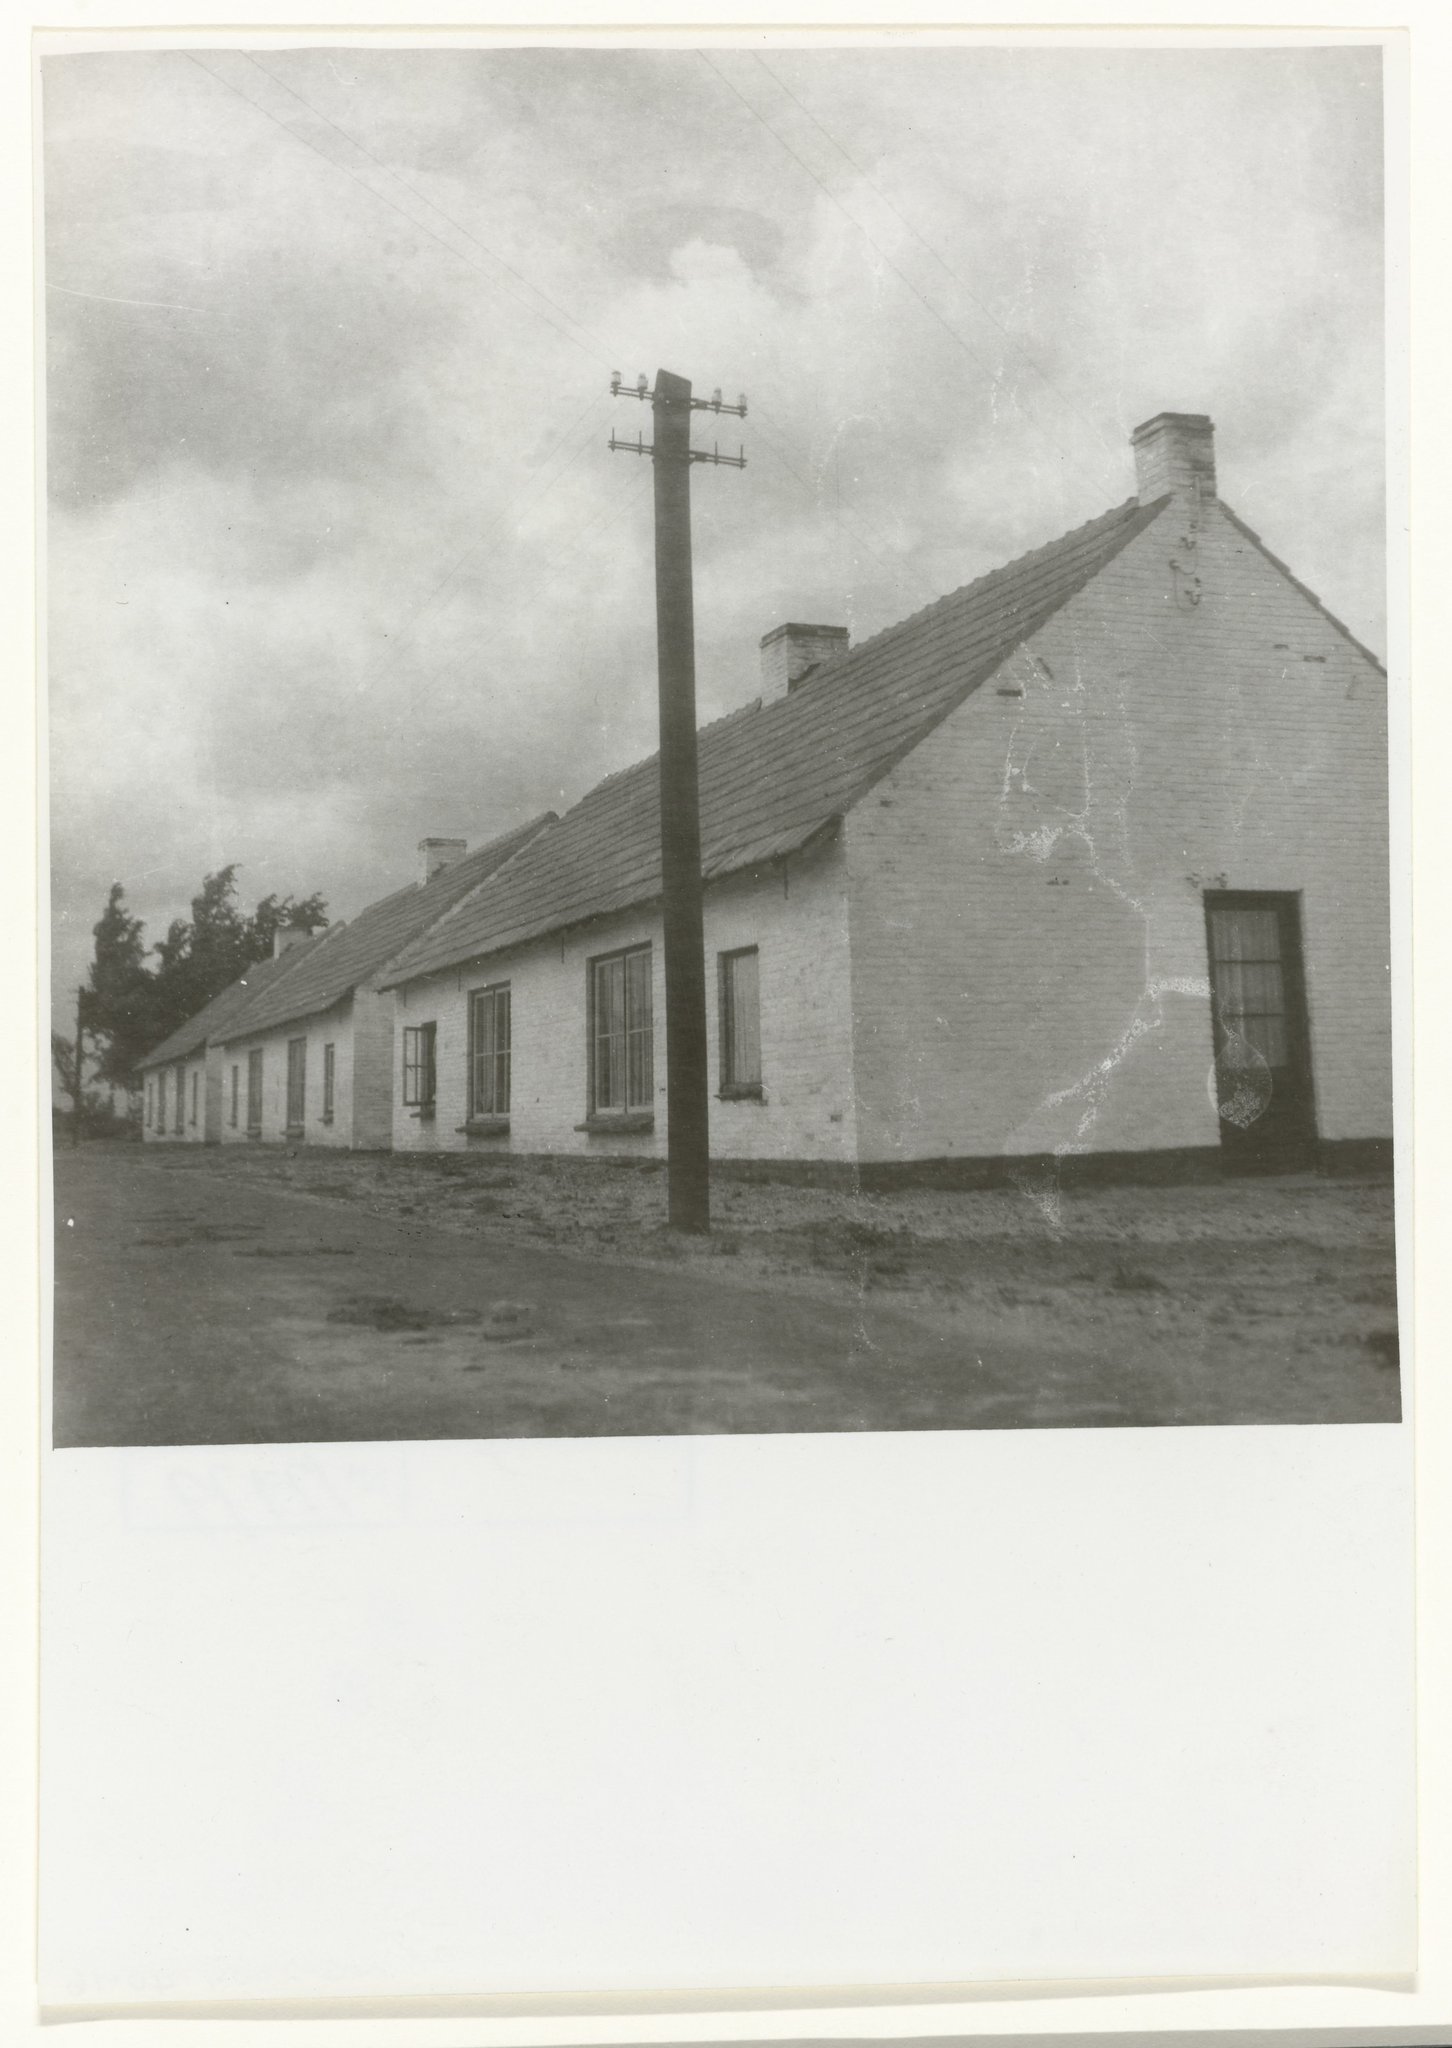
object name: documentary photograph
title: Huizenrij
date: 1945-1946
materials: photographic support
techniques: photography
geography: netherlands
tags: netherlands